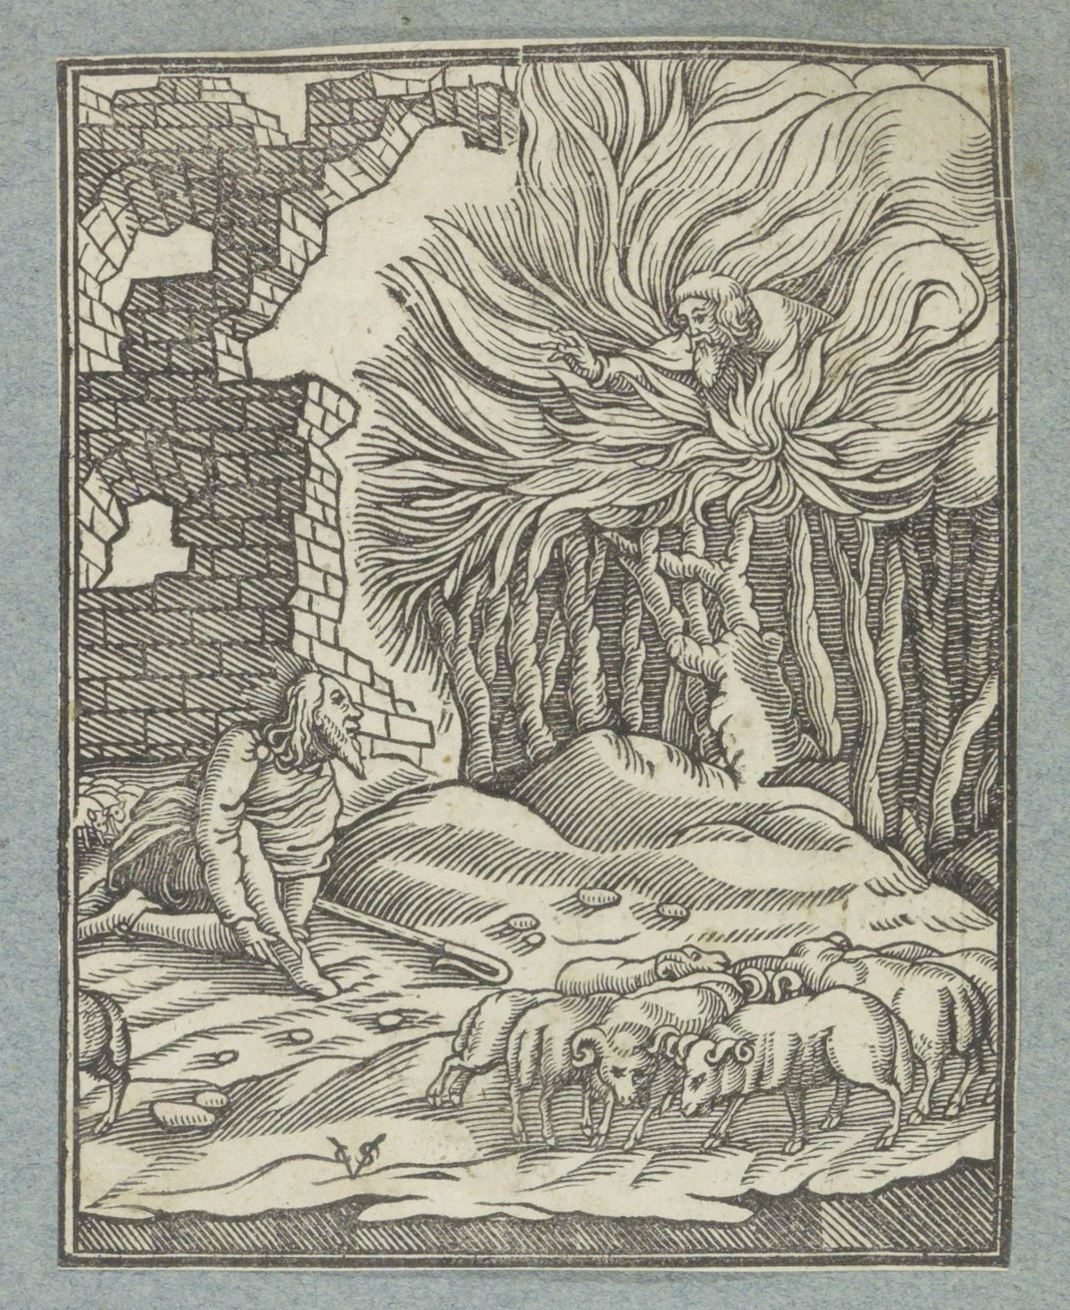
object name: album leaf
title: Mozes en de brandende braamstruik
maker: pieter jacobsz. paets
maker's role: publisher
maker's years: 1587-1667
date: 1645-1646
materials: paper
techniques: letterpress printing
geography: amsterdam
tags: a burning bush attracts moses' attention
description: Mozes in een landschap bij een ruïne, zijn schoen uittrekkend en met naast zich een herdersstaf. Rechts op de voorgrond de kudde van zijn schoonvader. In een visioen ziet Mozes naar braamstruik die brand zonder te verteren. God de Vader spreekt tot hem vanuit de struik. De prent maakt deel uit van een album.